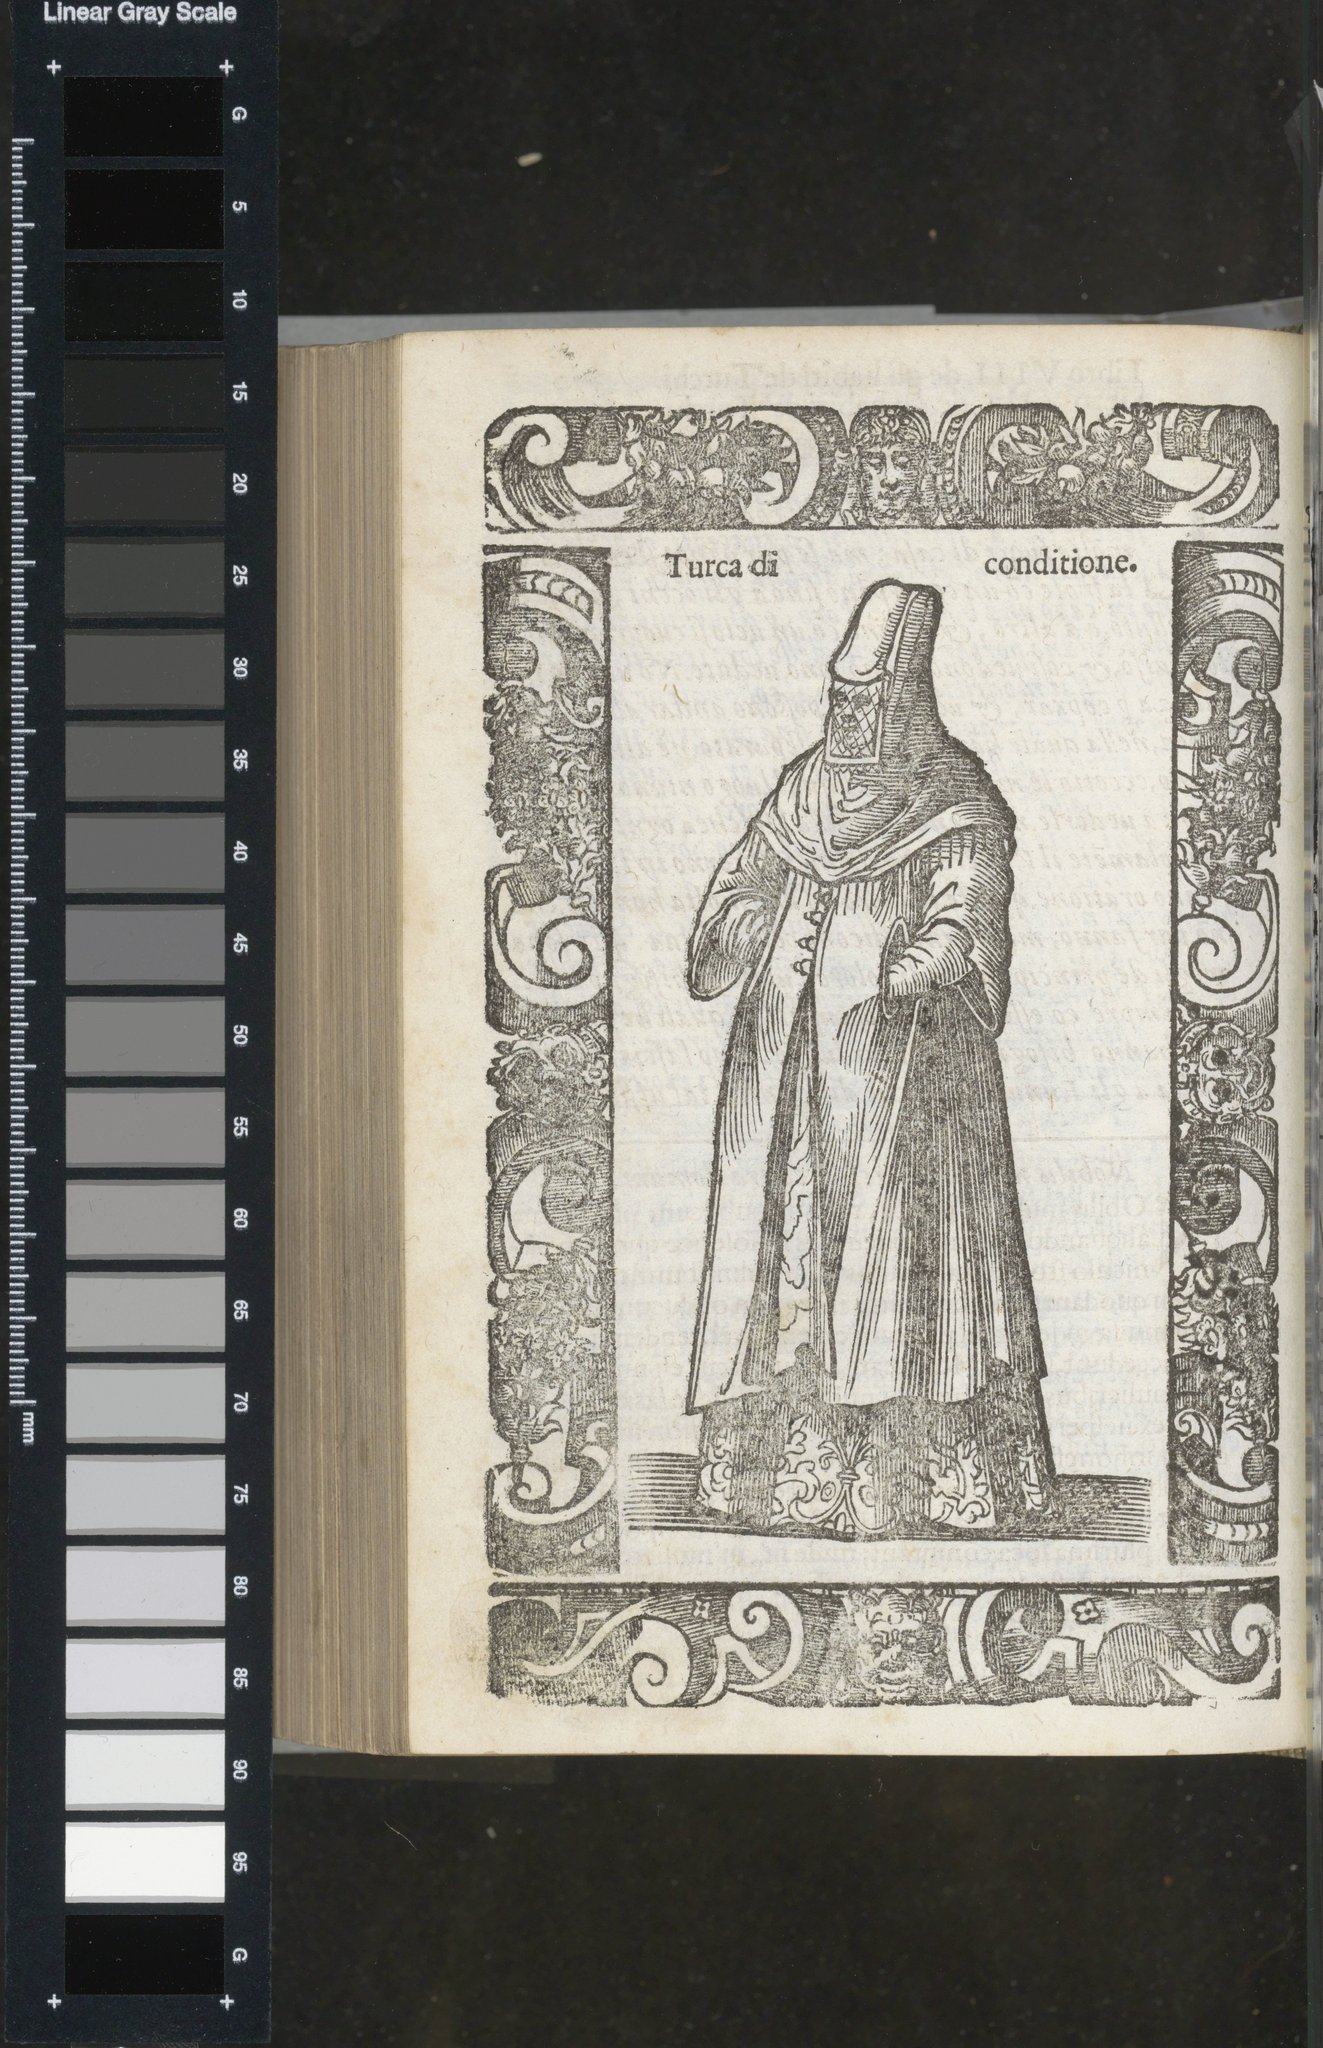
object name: costume print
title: Turca di conditione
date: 1598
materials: paper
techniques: woodcut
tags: fashion plates